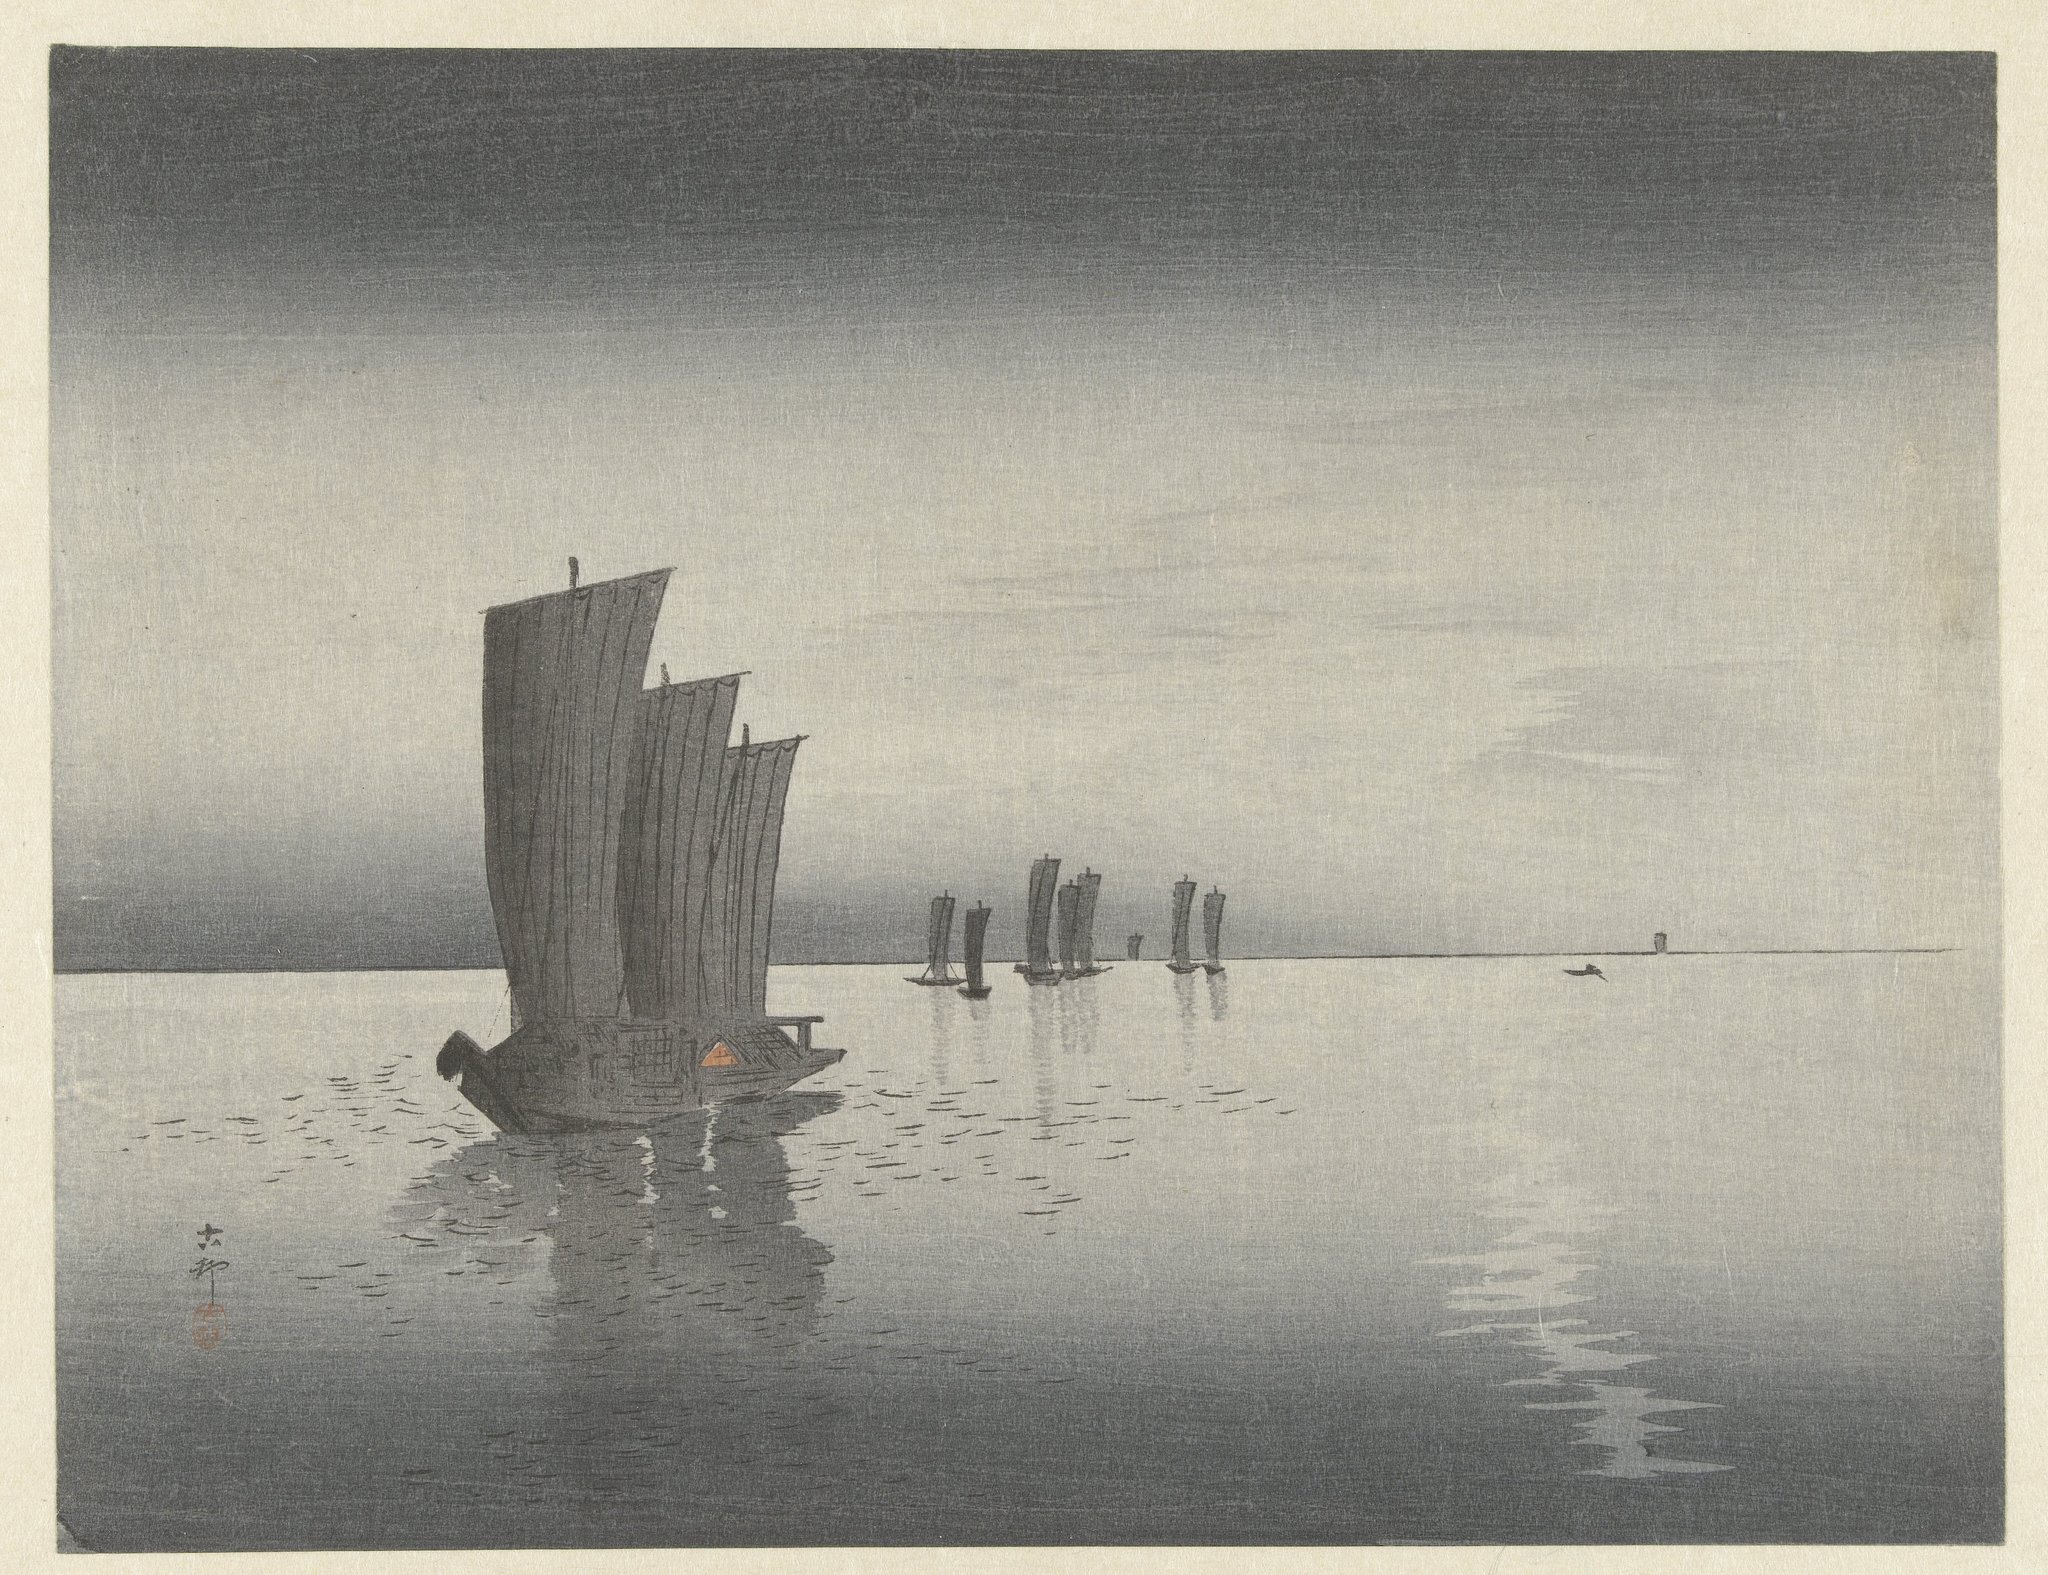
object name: print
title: Vissersboten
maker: ohara koson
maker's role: print maker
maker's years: 1877-1945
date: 1900-1920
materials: paper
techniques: woodcut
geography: japan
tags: sailing-ship, sailing-boat, night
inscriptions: collector's mark: Lugt 2760, collector's mark: Lugt 2228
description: Vissersboten met volle zeilen op kalm water; in de schemering.